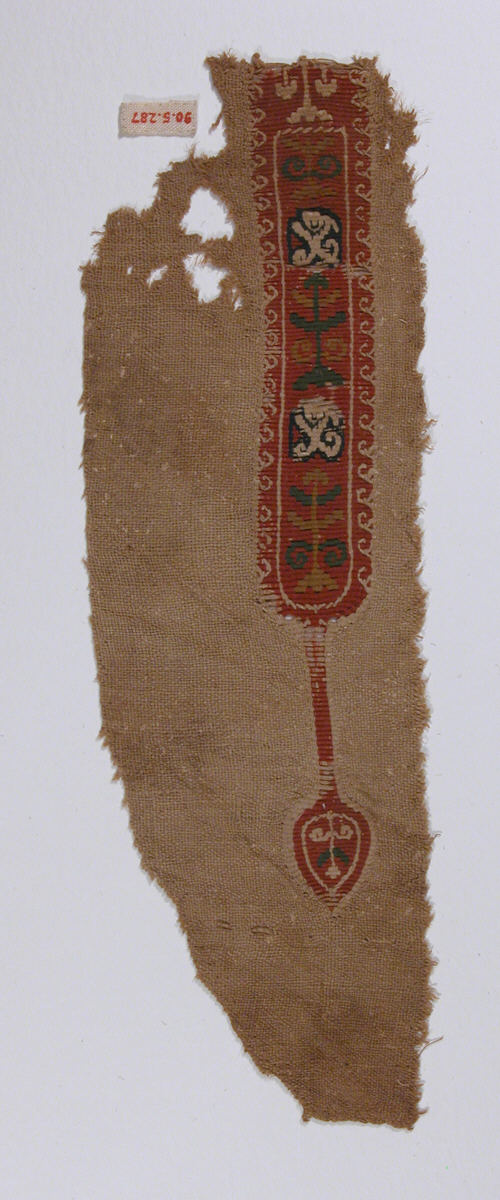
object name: textile fragment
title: Fragment of a Tunic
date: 401-600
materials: linen, wool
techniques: weave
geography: egypt